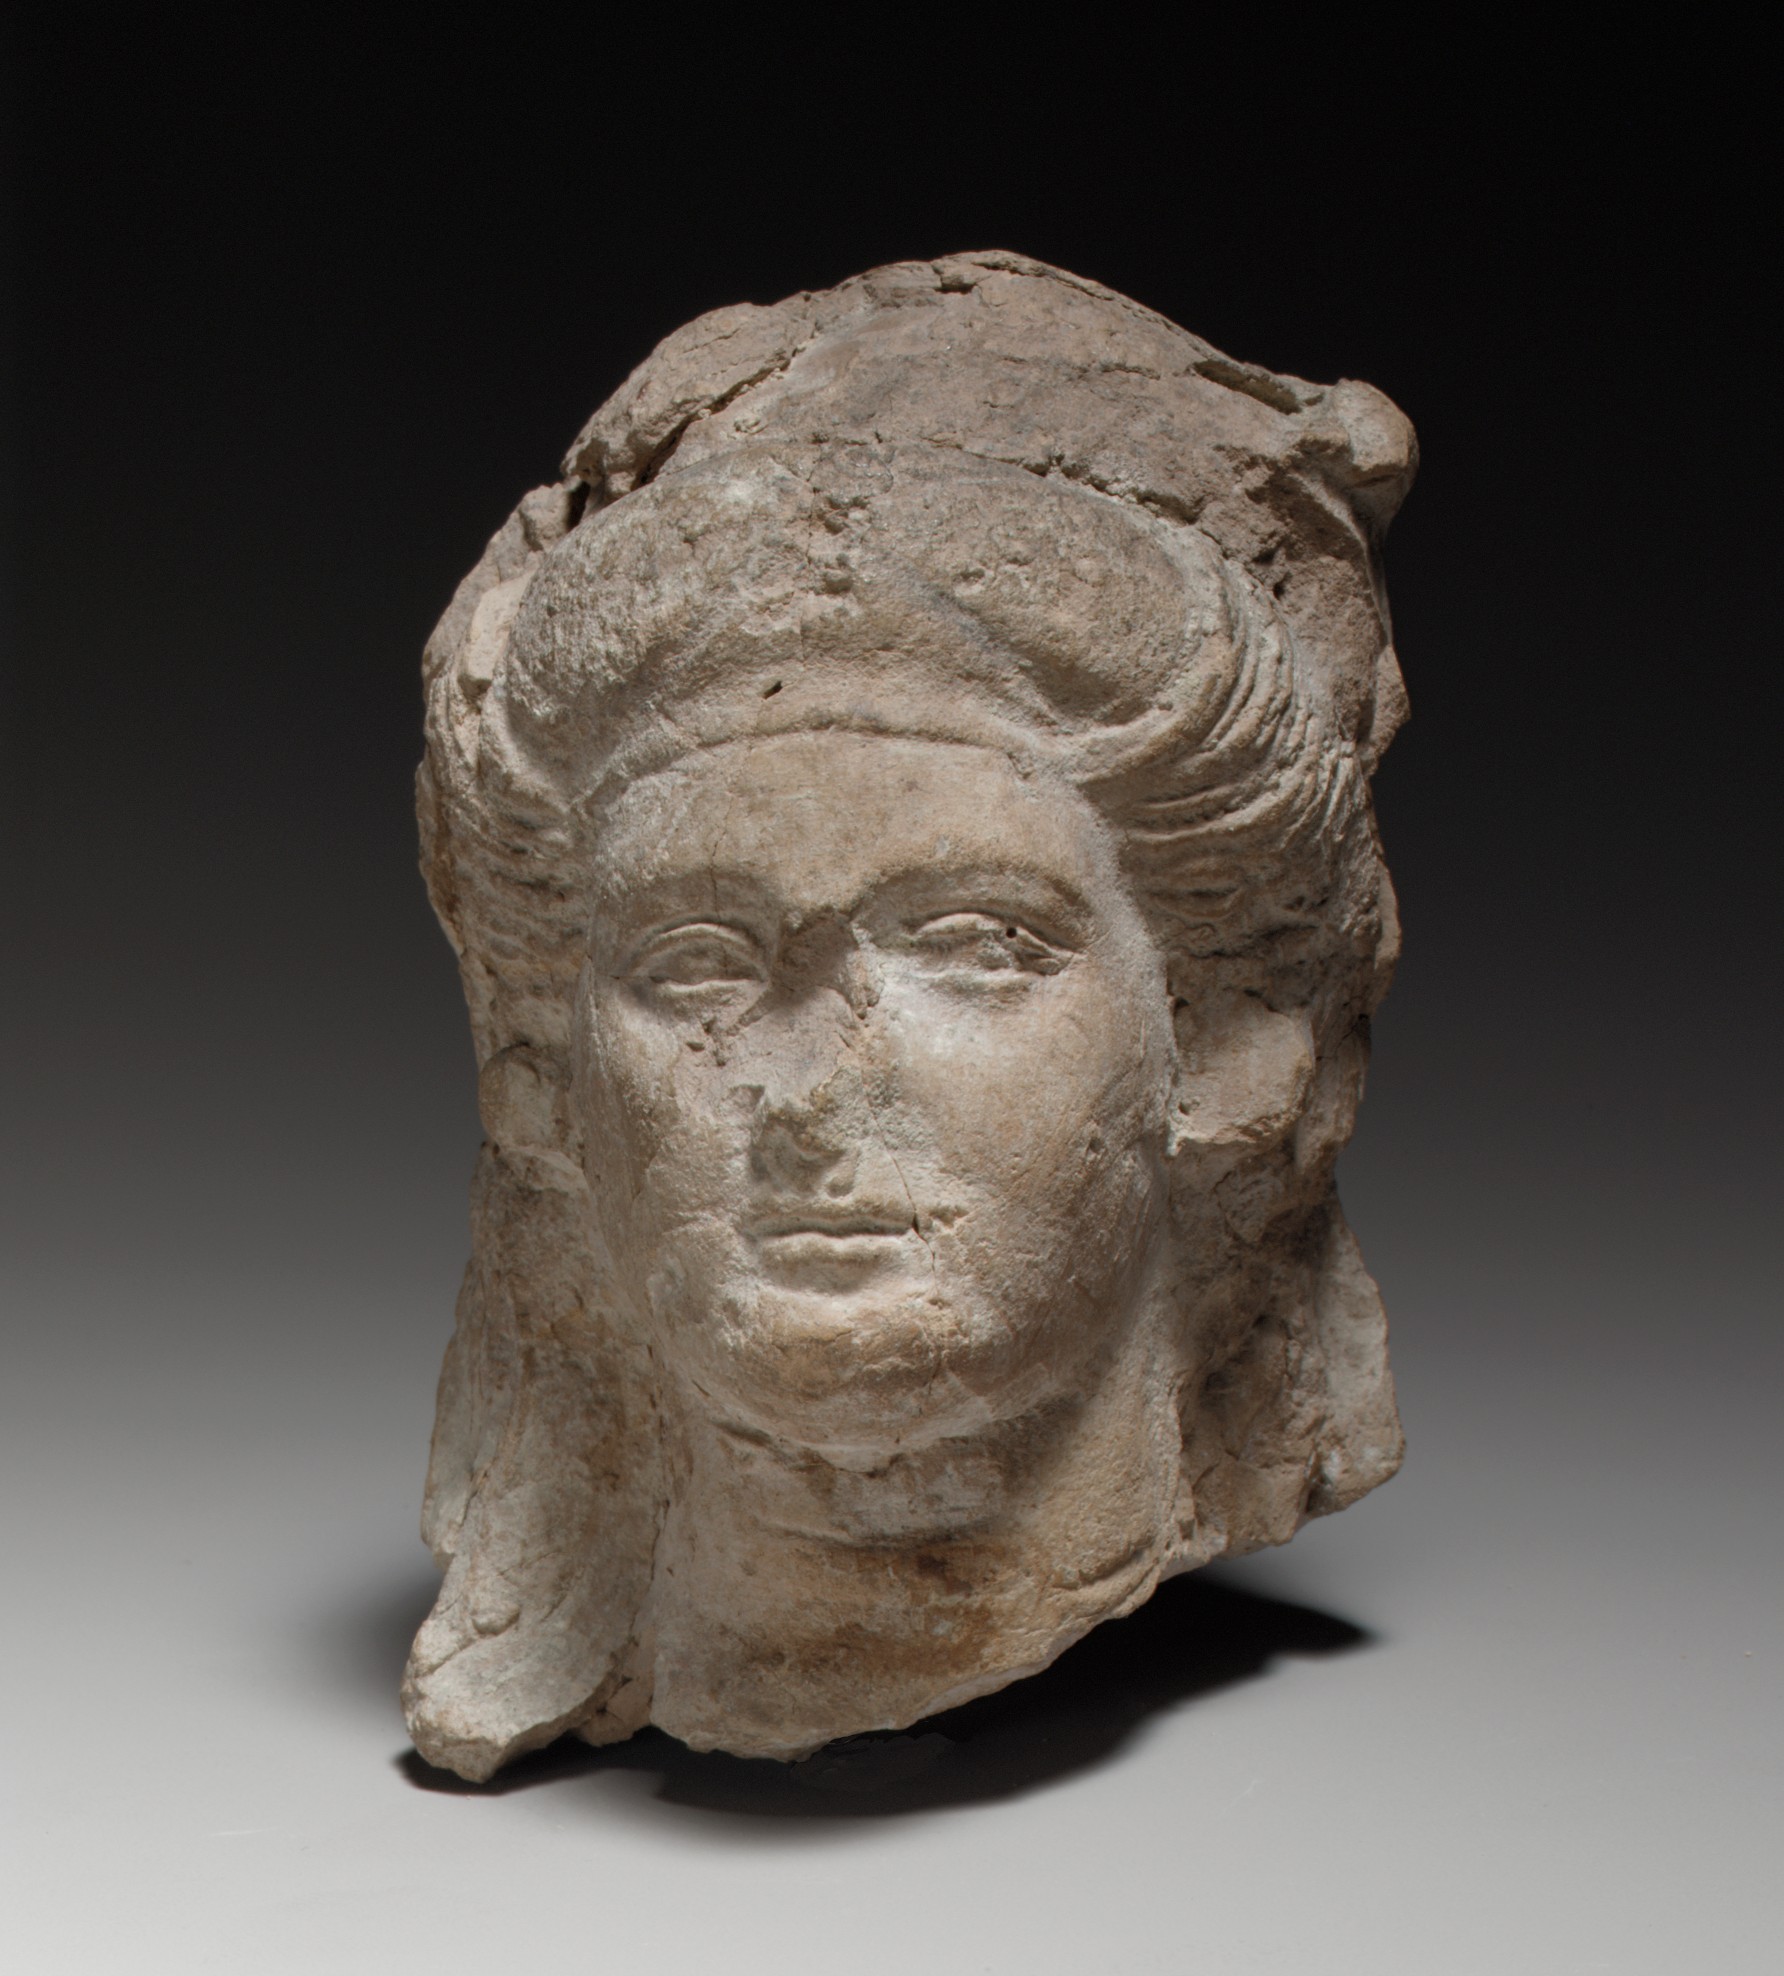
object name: head of a goddess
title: Female head, probably of a goddess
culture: cypriot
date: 400-301 BCE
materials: terracotta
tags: heads,goddess